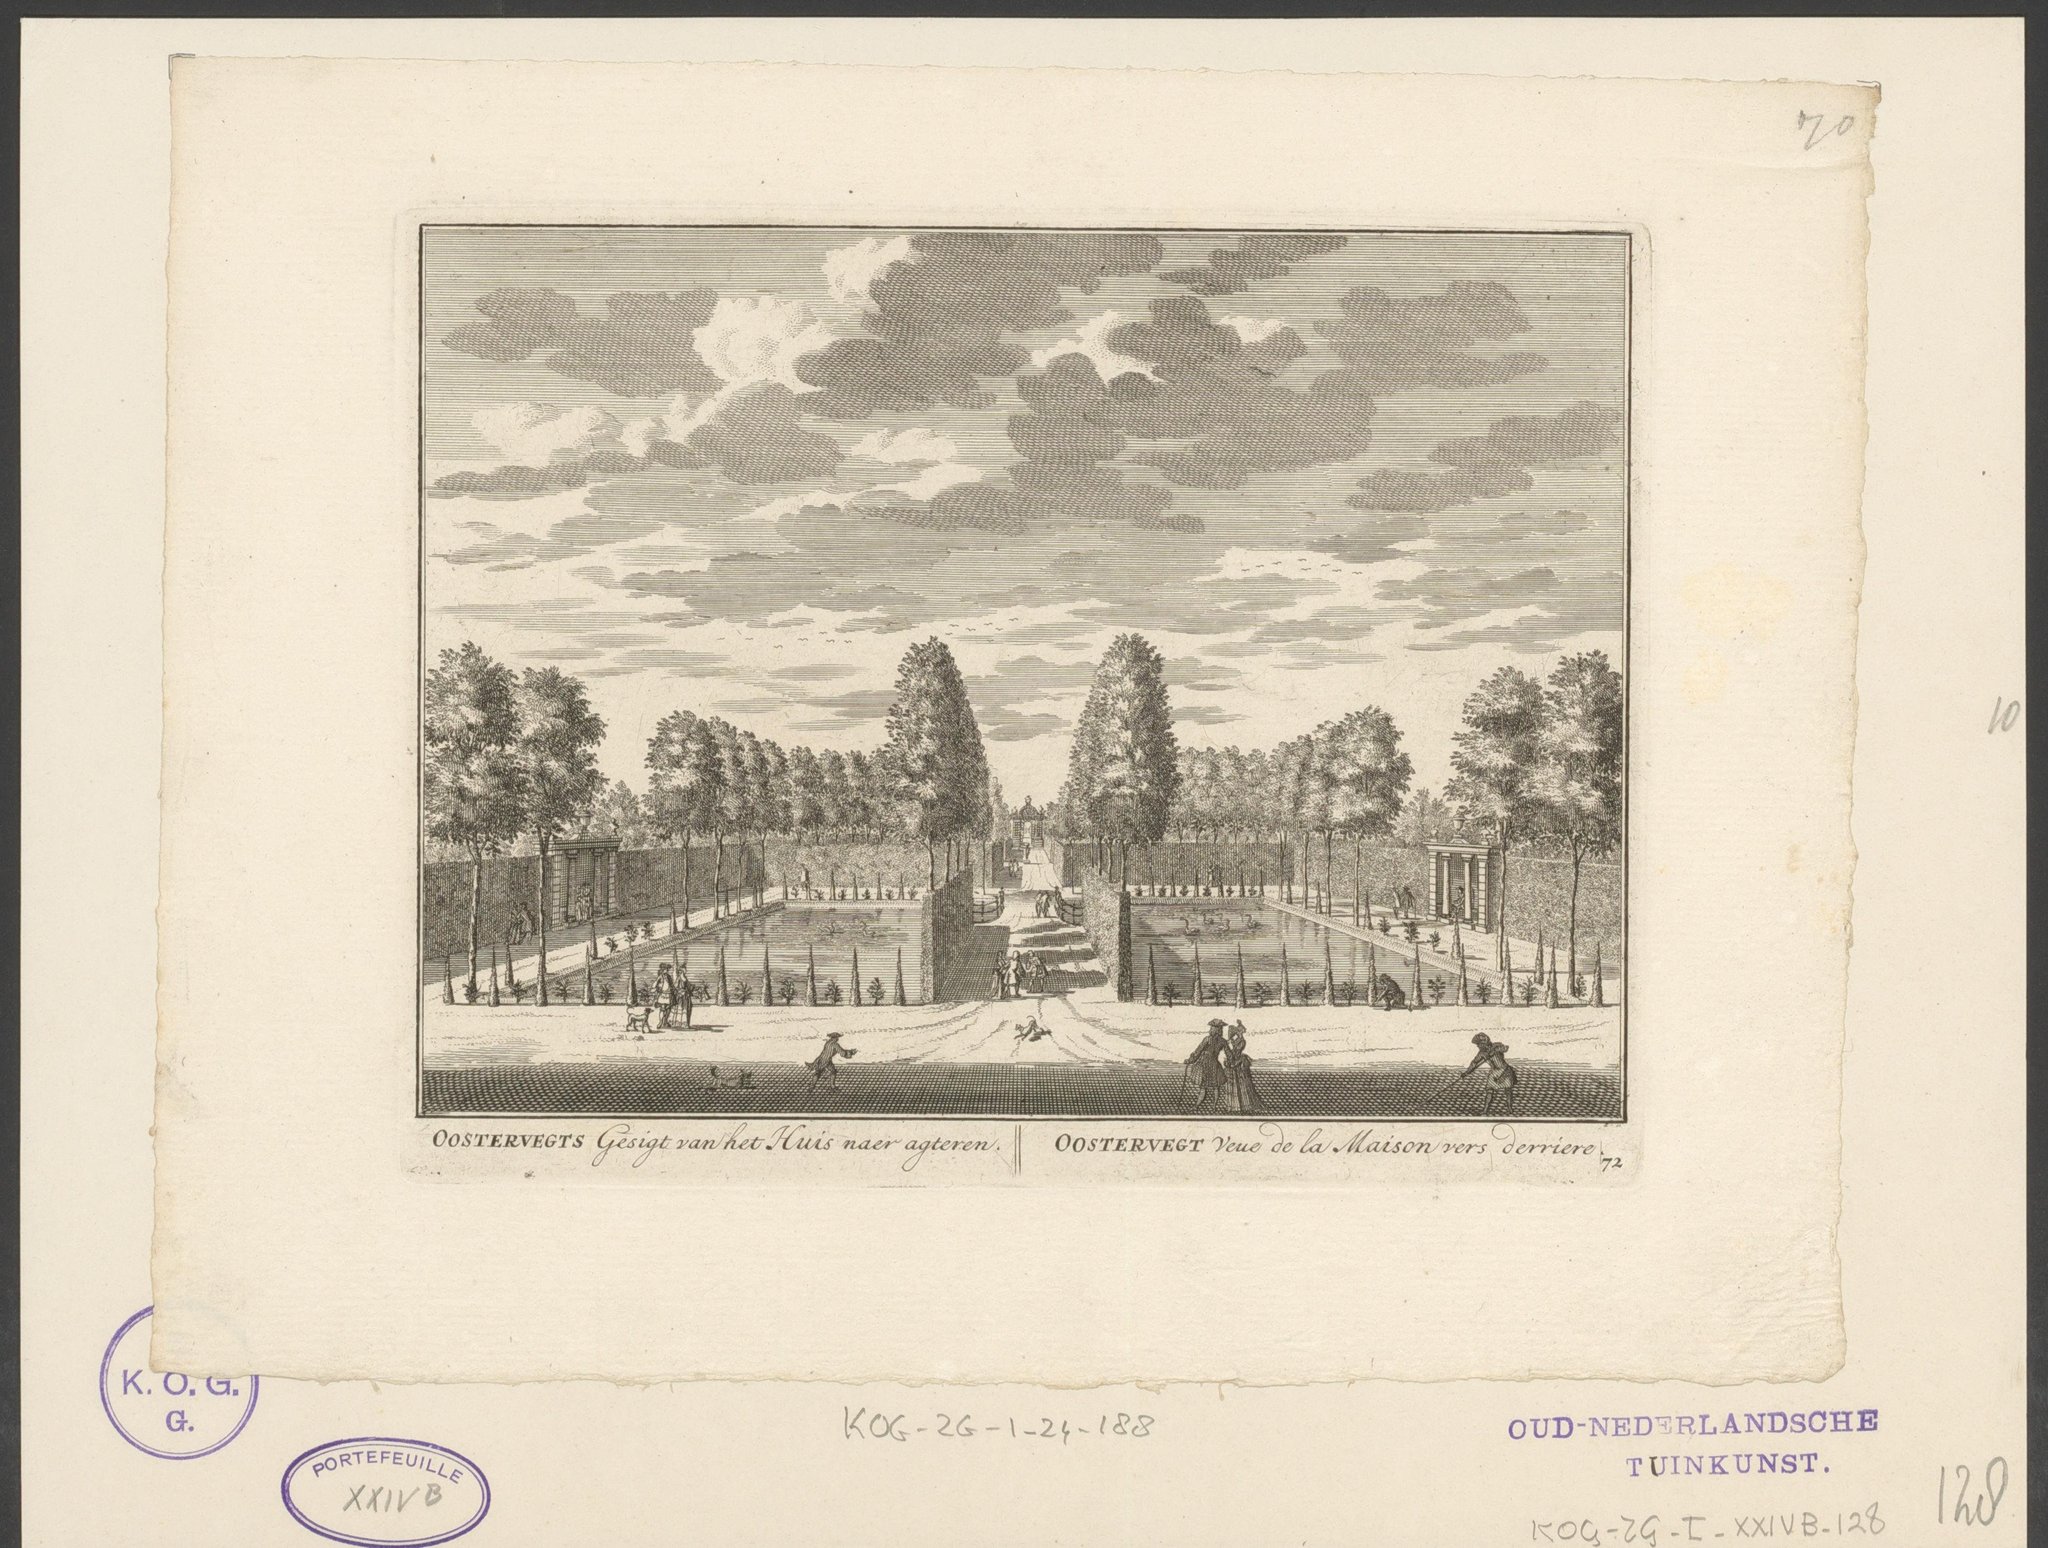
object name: print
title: Gezicht op de tuinen van buitenplaats Oostervecht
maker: hendrik de leth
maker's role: draughtsman, print maker, publisher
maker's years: 1703-1766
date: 1729-1732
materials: paper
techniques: engraving, etching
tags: french or architectonic garden; formal garden, country-house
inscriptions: stamp, collector's mark: Lugt 1641, stamp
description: Prent mogelijk uit: Brouërius van Nidek, Matthaeus. Het zegepralend Kennemerland, vertoond in 100 heerlyke gezichten. Amsterdam: Jan Roman, s.a. Of uit: Brouërius van Nidek, Matthaeus. Het zegepralend Kennemerland, vertoond in veele heerlyke gezichten. Amsterdam: Andries en Hendrik de Leth, s.a [1729-1732]. Of uit: Brouërius van Nidek, Matthaeus. Het zegepralend Kennemerland, vertoond in veele heerlyke gezichten. Amsterdam: Jan Roman, s.a.